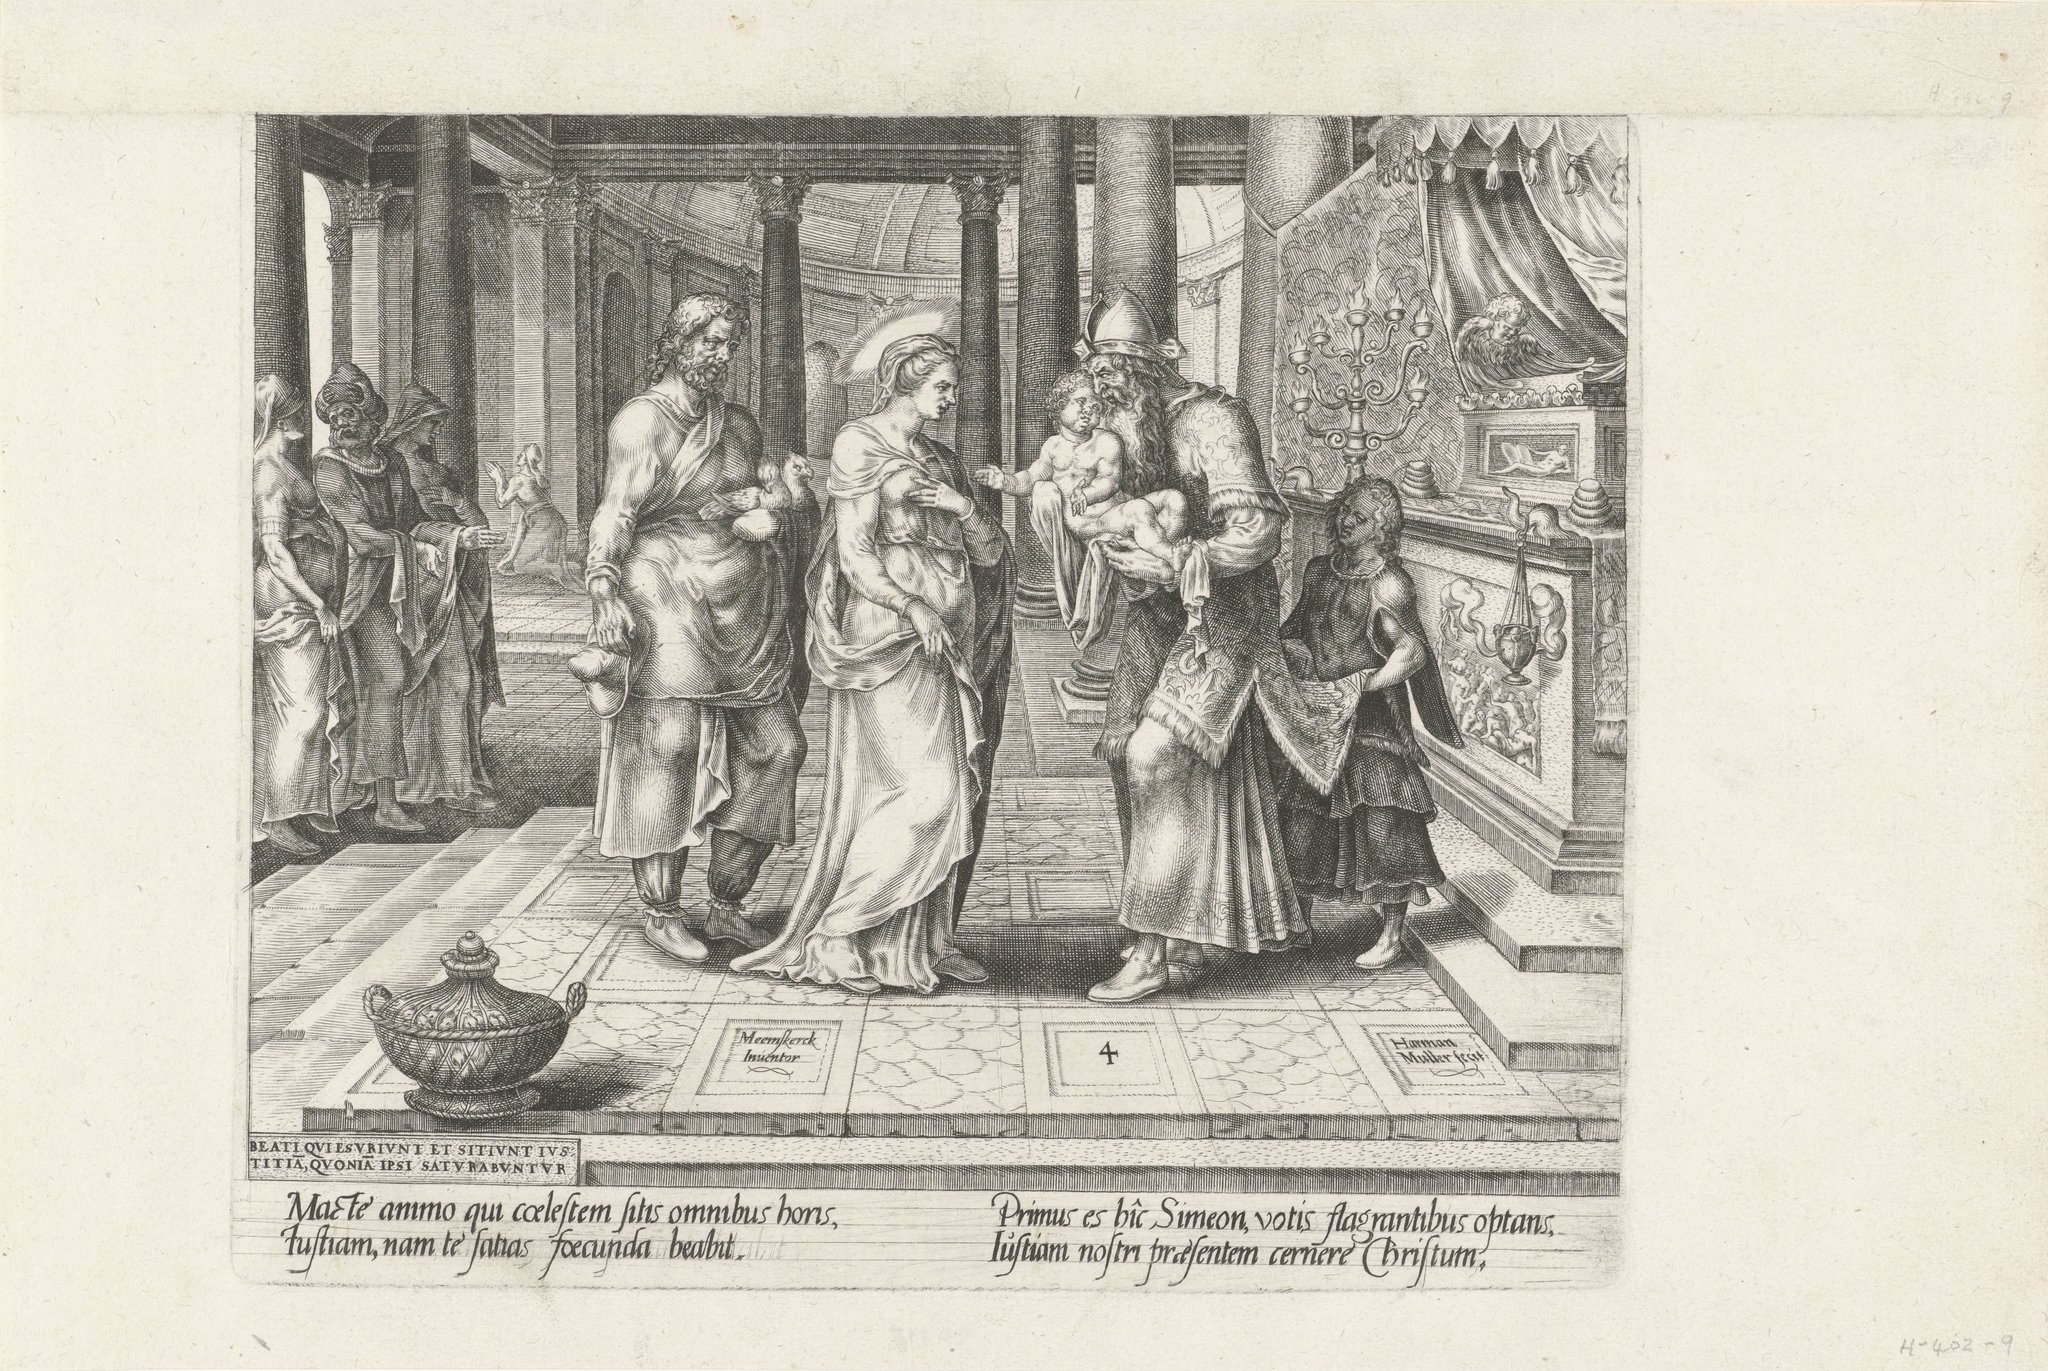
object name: print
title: De acht zaligsprekingen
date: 1564-1568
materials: paper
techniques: engraving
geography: amsterdam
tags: blessed are those who hunger and thirst after righteousness, presentation of the christ-child in the temple, usually simeon (and anna) present (luke 2:22-39)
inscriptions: collector's mark: Lugt 2228, collector's mark: Lugt 2760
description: Jozef, met twee duiven op de arm, en Maria, presenteren Christus in de tempel. De rechtvaardige Simeon houdt het kind vast voor het altaar. Links op de achtergrond de biddende profetes Hanna. Prent maakt deel uit van een serie over de acht zaligsprekingen van Christus en illustreert de zaligspreking: Zalig wie hongeren en dorsten naar gerechtigheid. In de linker benedenhoek deze tekst uit Mat. 5:6 in het Latijn. Onderaan in de marge een vers in het Latijn over Simeon, wiens honger en dorst naar gerechtigheid werden gestild, toen hij Christus zag en vasthield.